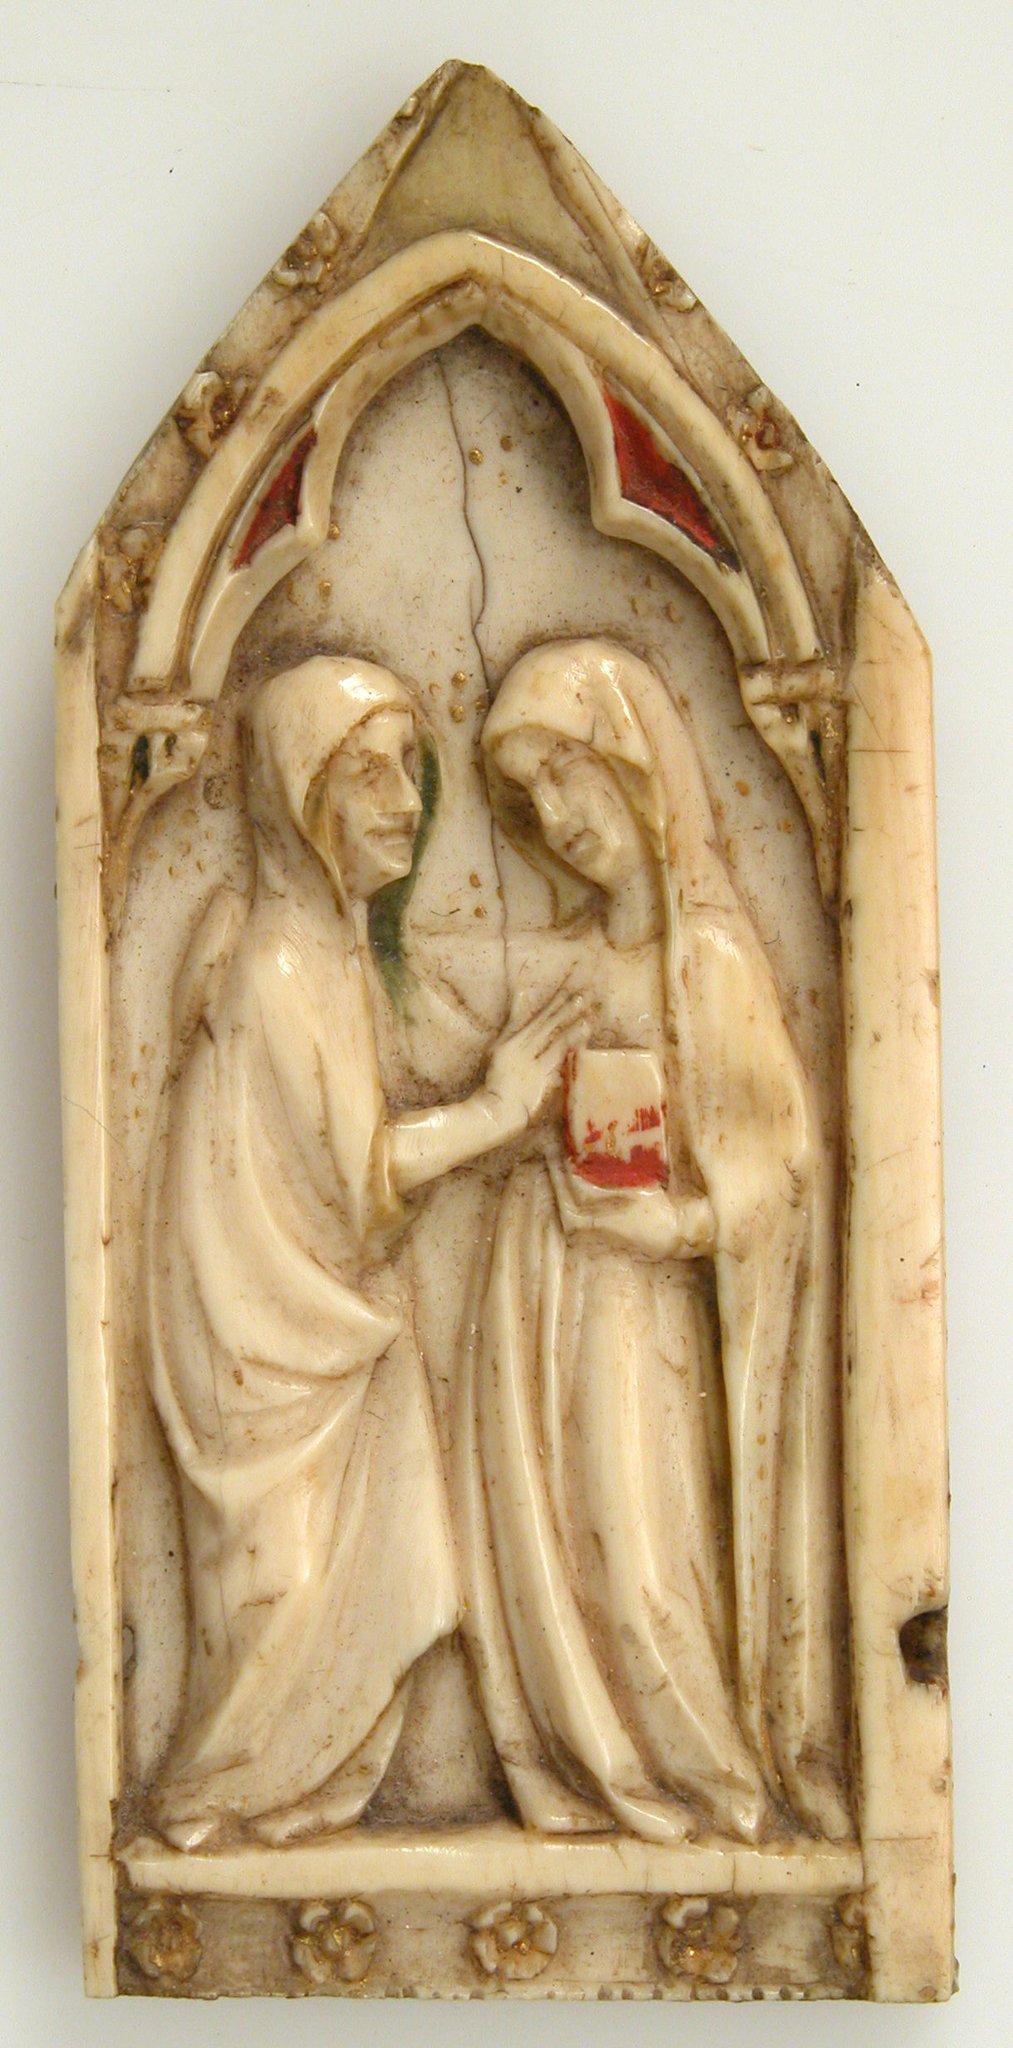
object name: plaque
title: Plaque with the Visitation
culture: french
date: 1301-1400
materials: ivory, paint